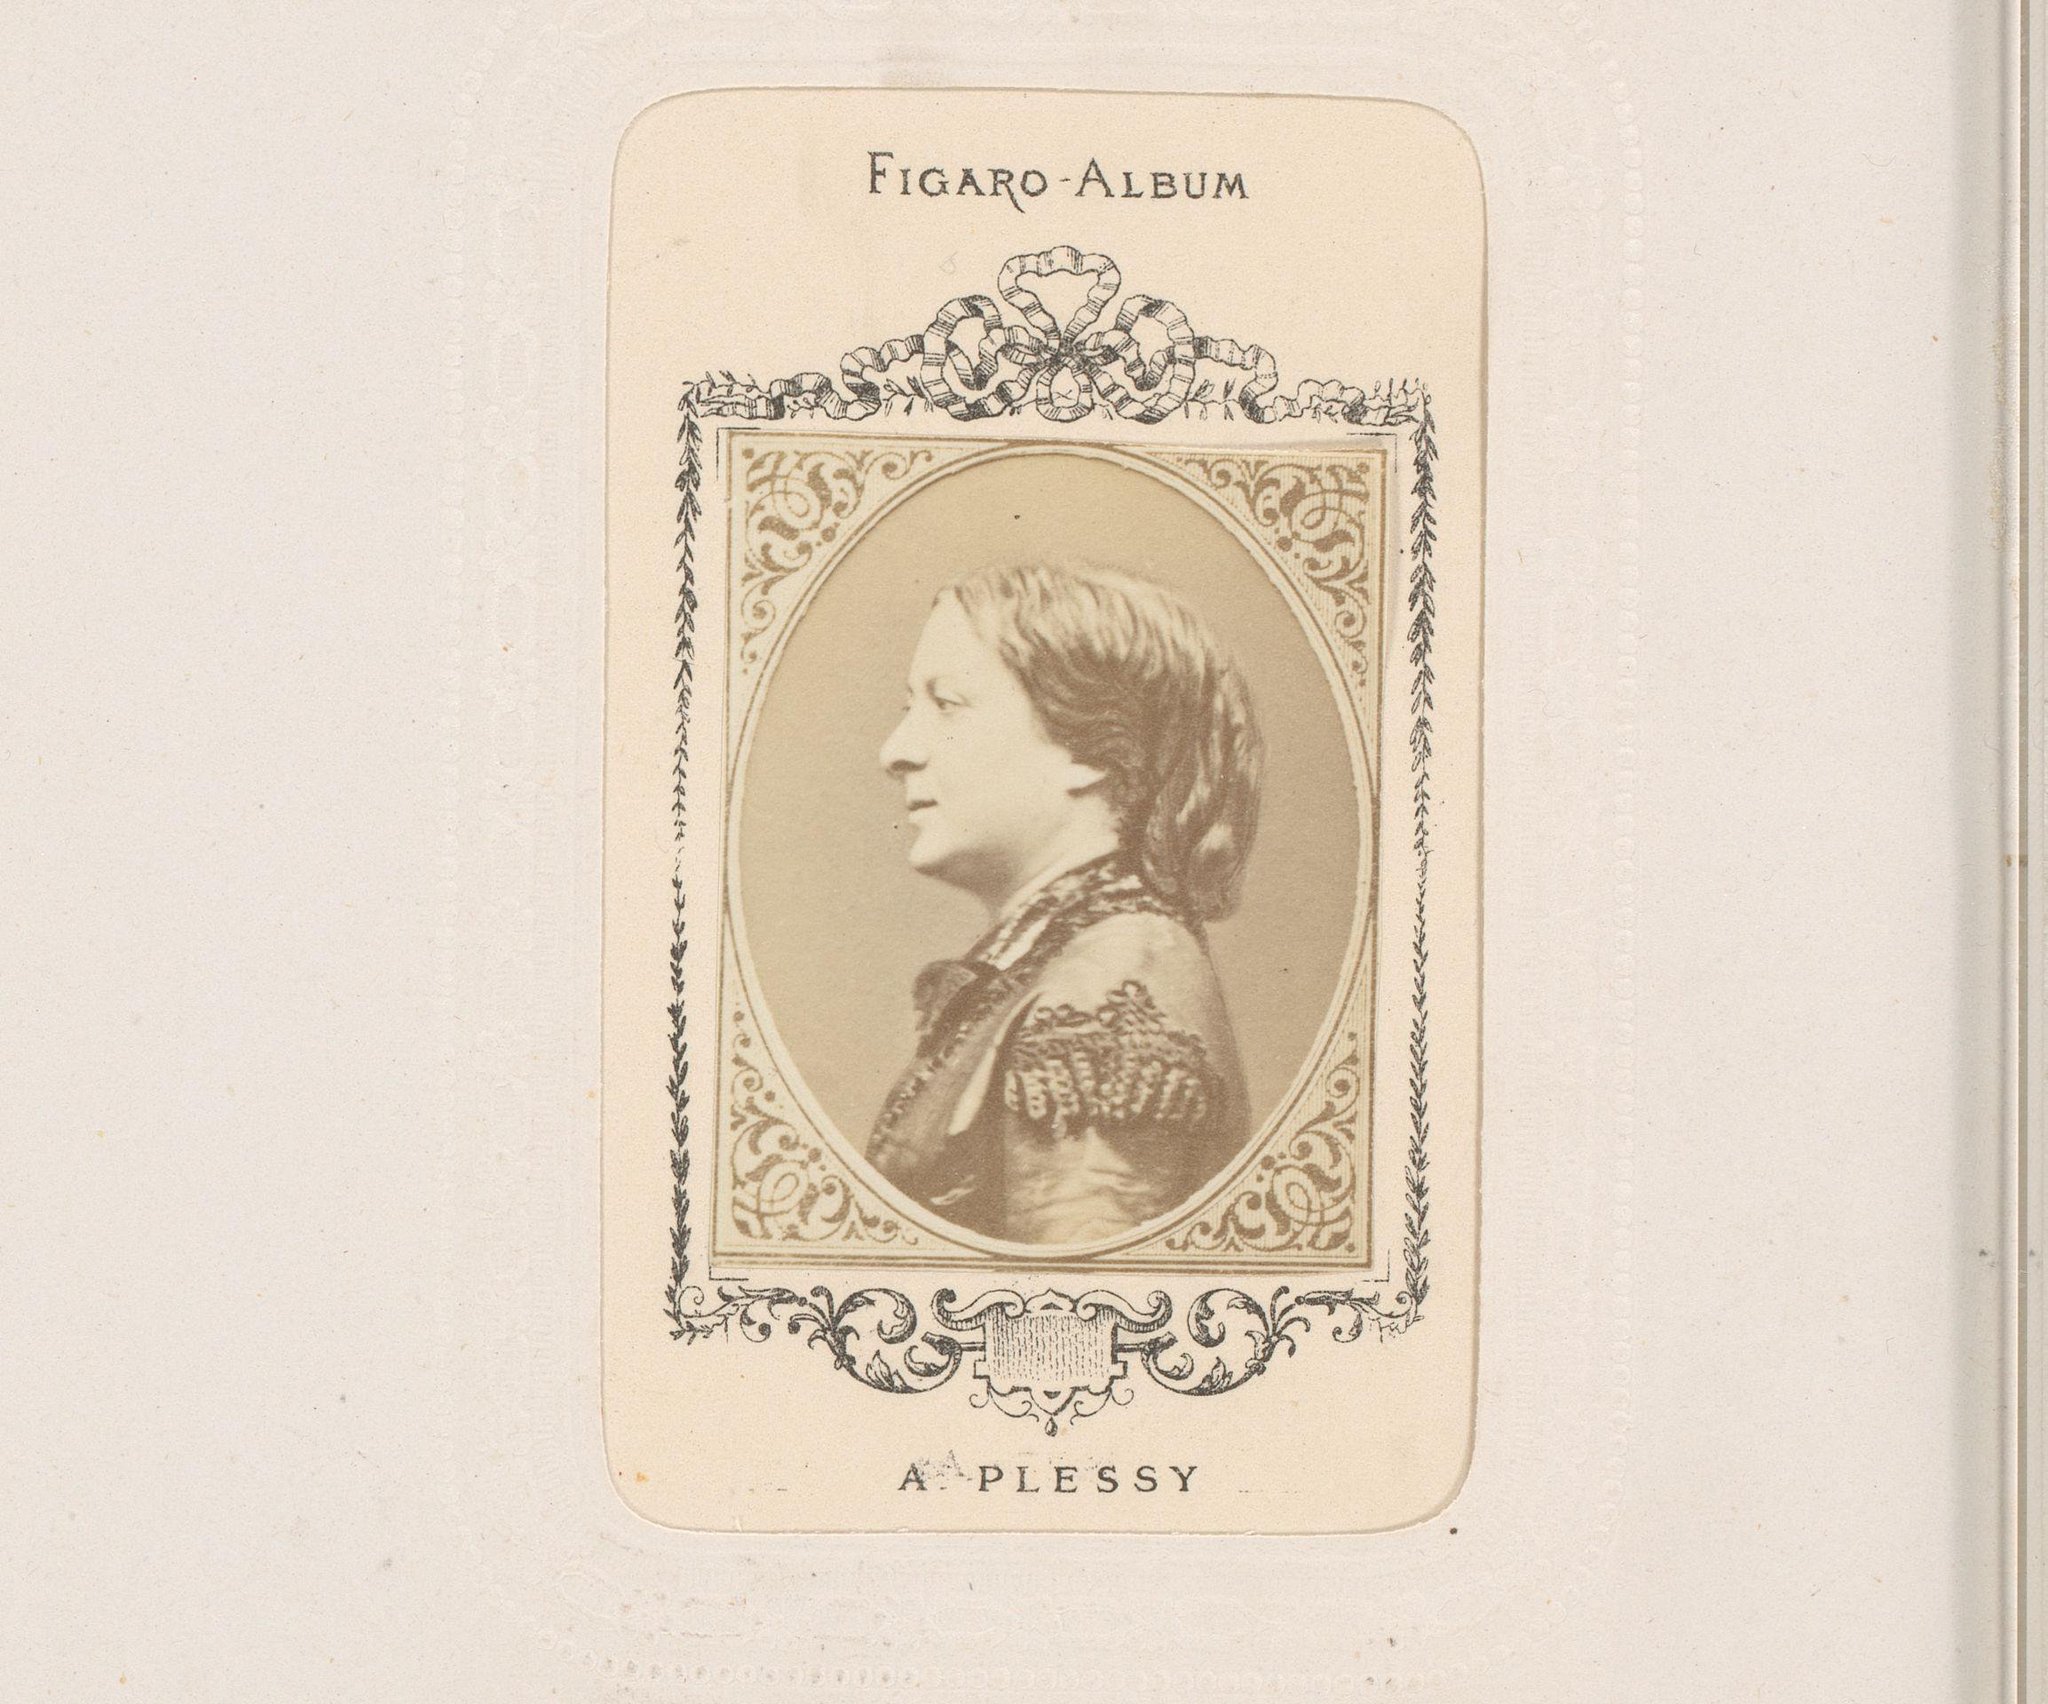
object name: reproduction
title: Fotoreproductie van een portret van Jeanne-Sylvanie-Sophie Arnould-Plessy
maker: Anonymous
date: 1860-1900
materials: cardboard, photographic support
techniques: albumen print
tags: historical persons - bb - woman, portrait of actor, actress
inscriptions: inscription: ‘Figaro-Album/ A. Plessy/ d'après Legé et Bergeron Phot.’